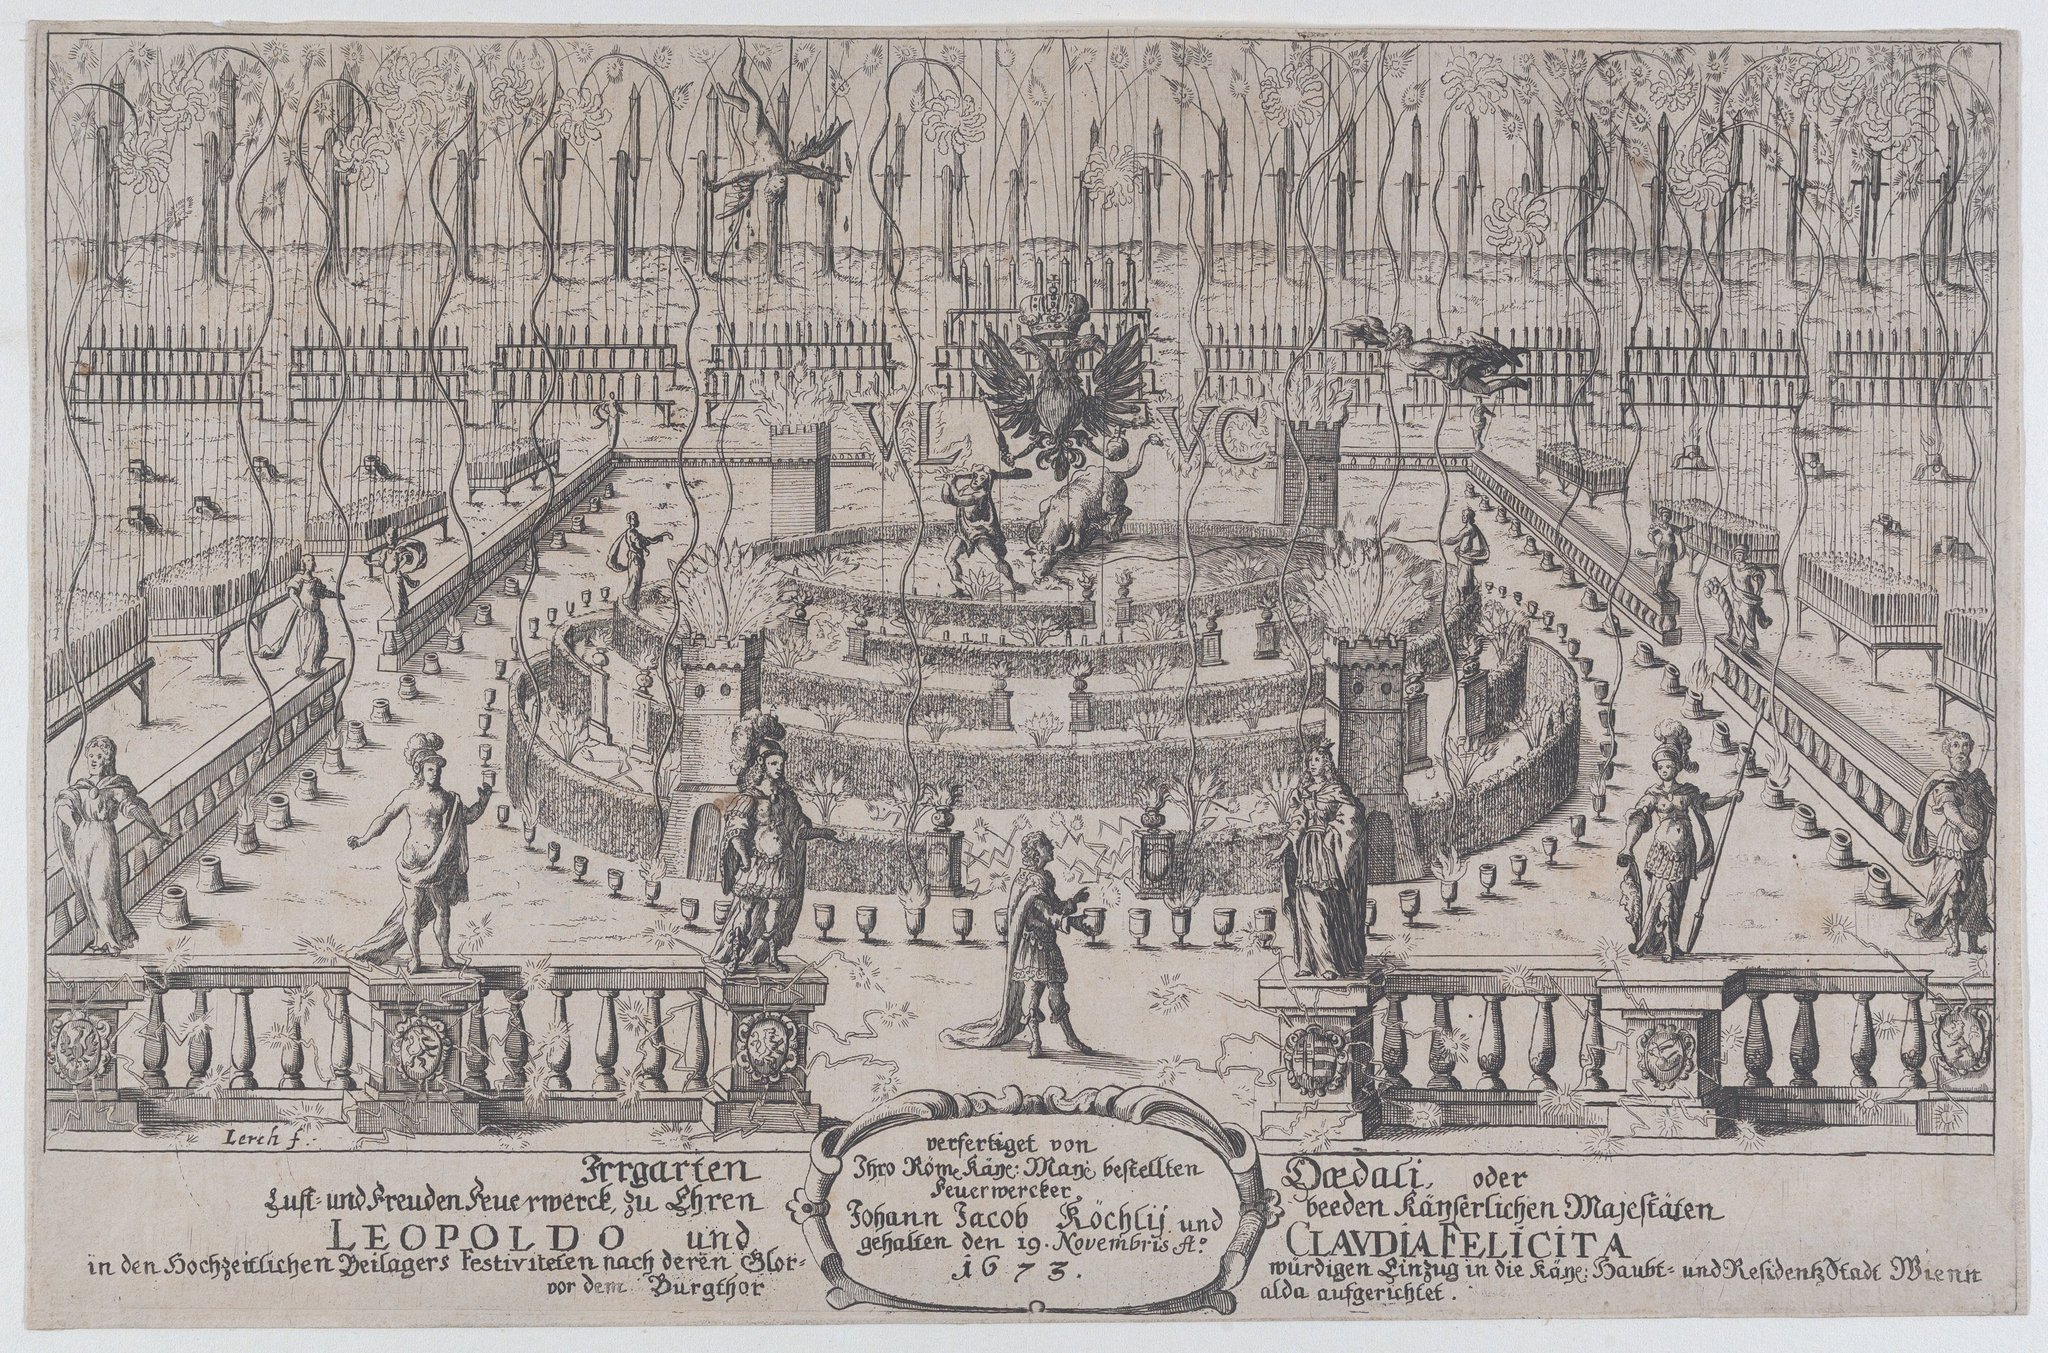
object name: print, fete, ornament architecture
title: Fireworks display, Nuremberg, 1659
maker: Anonymous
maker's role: artist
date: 1673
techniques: etching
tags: human figures,fireworks